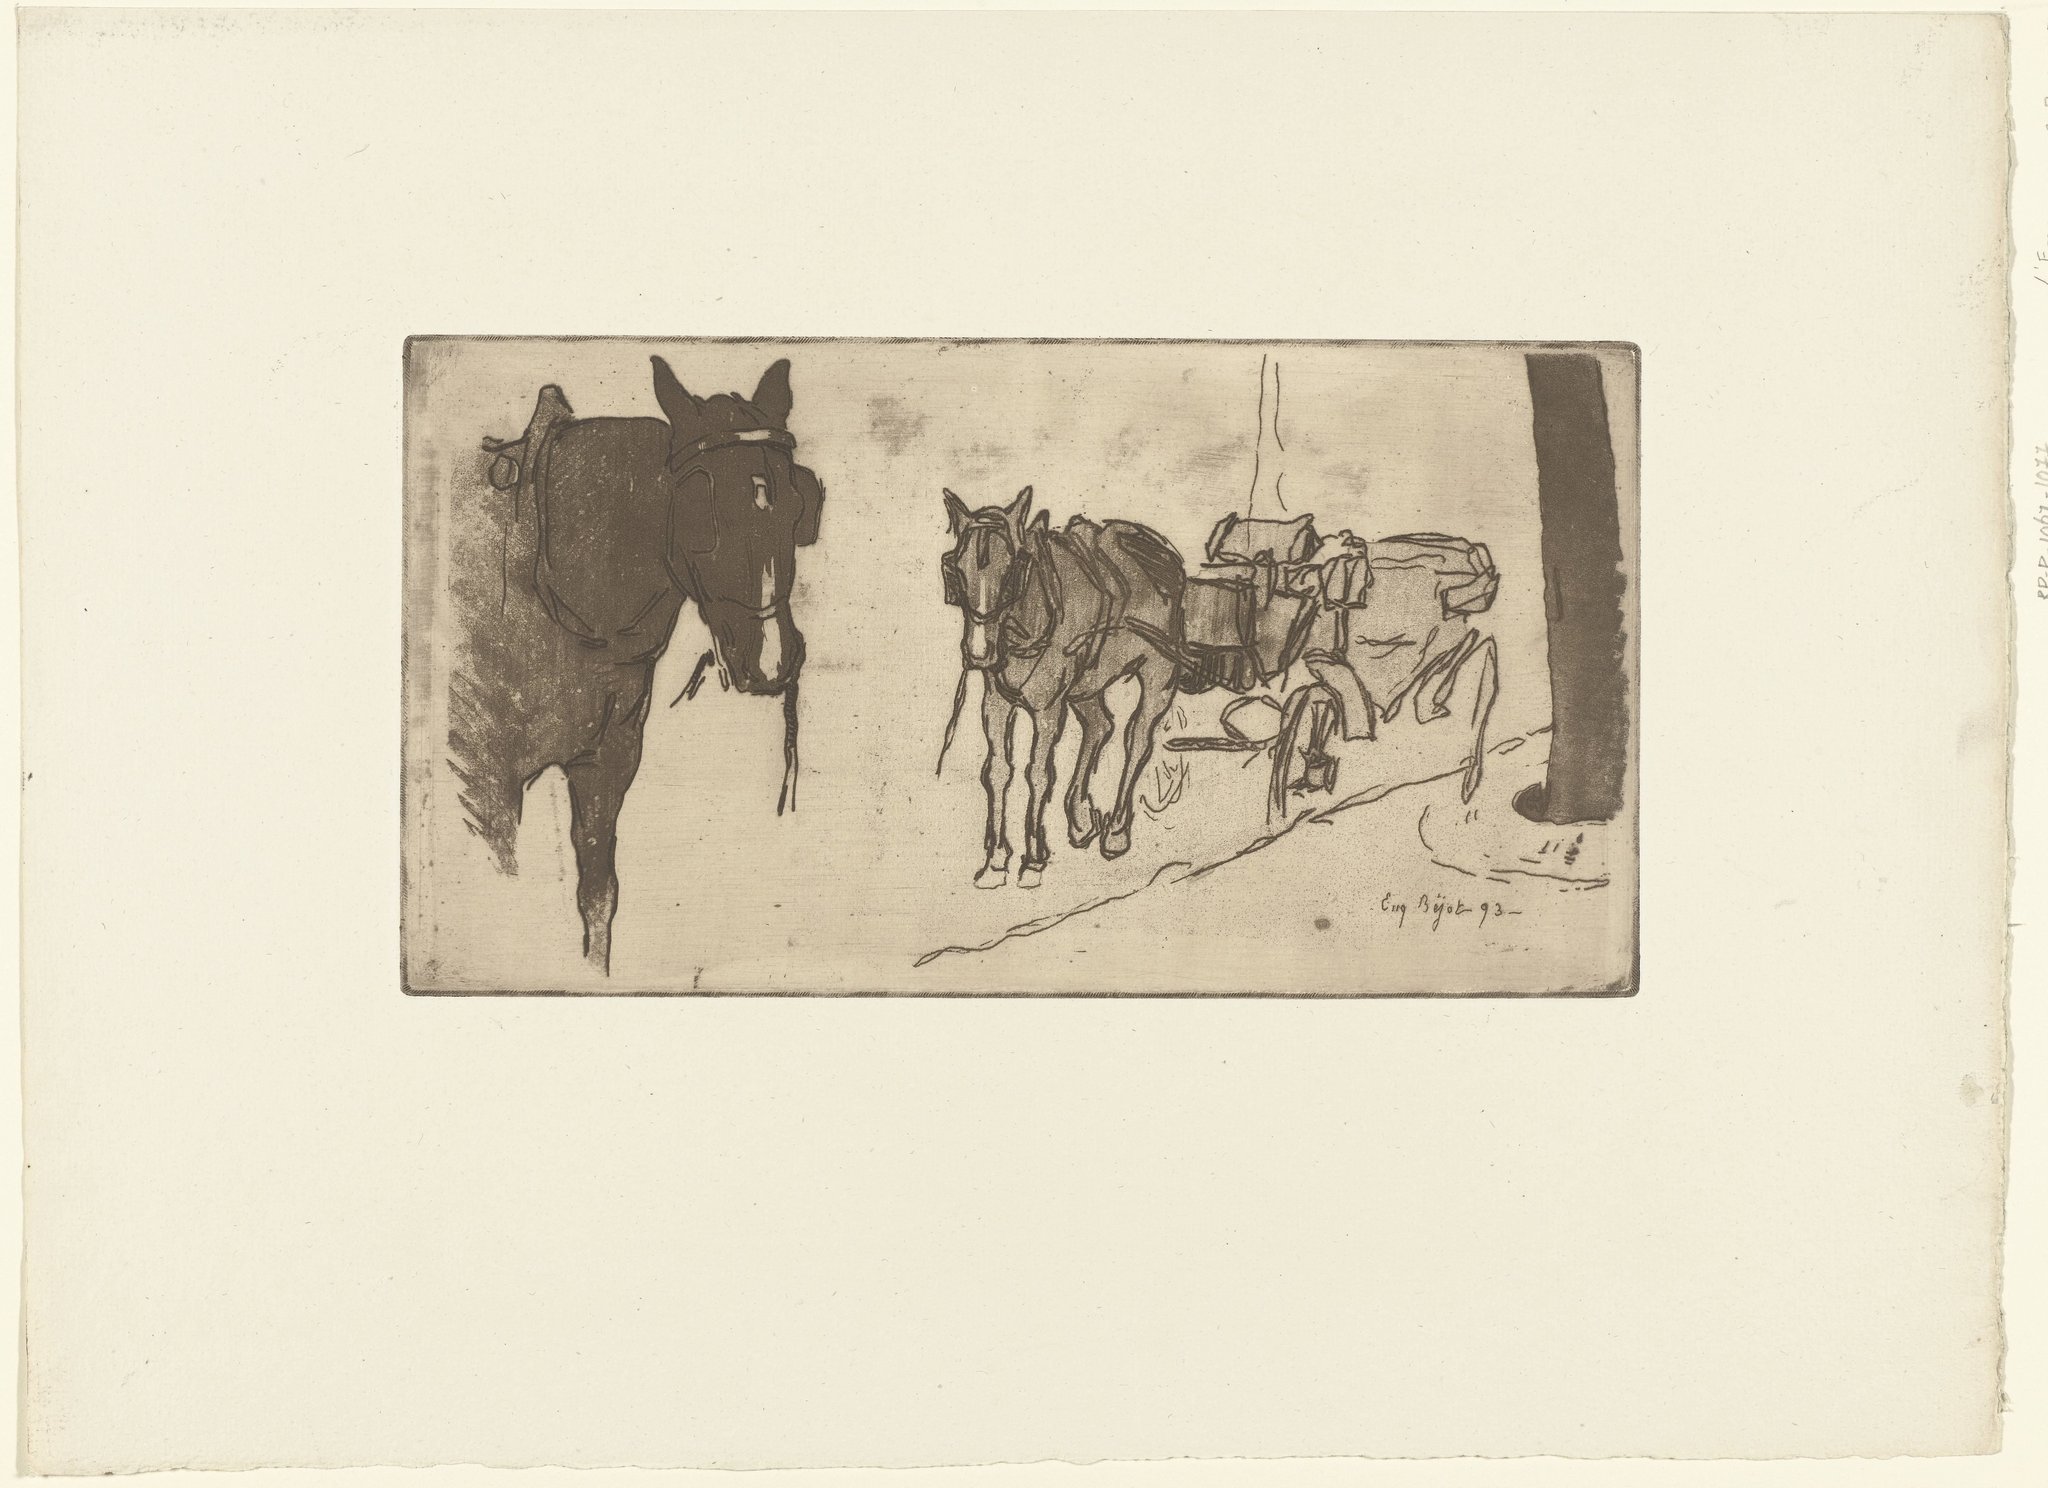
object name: print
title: L'Epreuve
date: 1893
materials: paper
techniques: aquatint, soft ground etching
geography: paris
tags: four-wheeled, animal-drawn vehicle, e.g.: cab, carriage, coach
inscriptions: collector's mark: Lugt 2228, collector's mark: Lugt 2760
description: Verschenen in album met tien originele prenten als supplement bij tijdschrift: L'Epreuve, april 1895, prent nr. 7